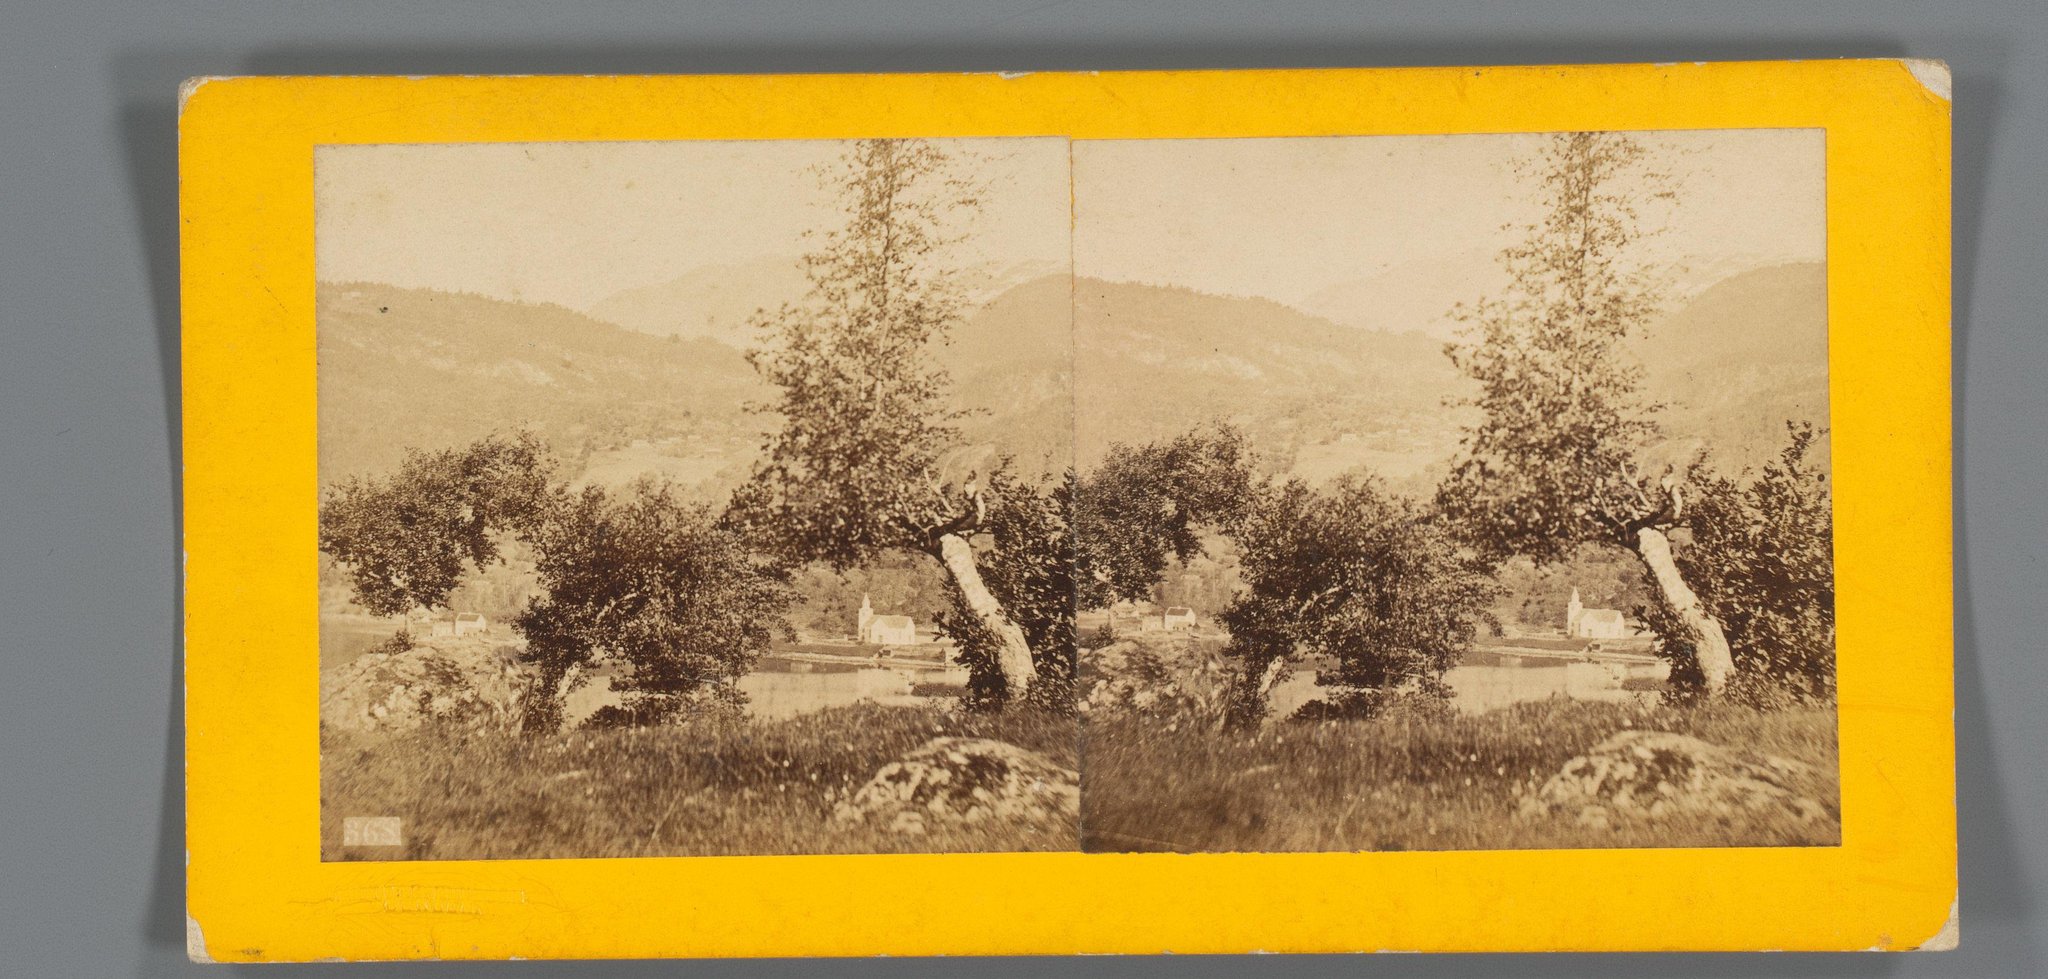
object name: stereograph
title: Parti fra Ulvik i Hardanger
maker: knud knudsen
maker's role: fotograaf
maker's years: 1832-1915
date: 1861-1870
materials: cardboard, paper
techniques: albumen print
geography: ulvik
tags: landscapes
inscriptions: number: ‘368’